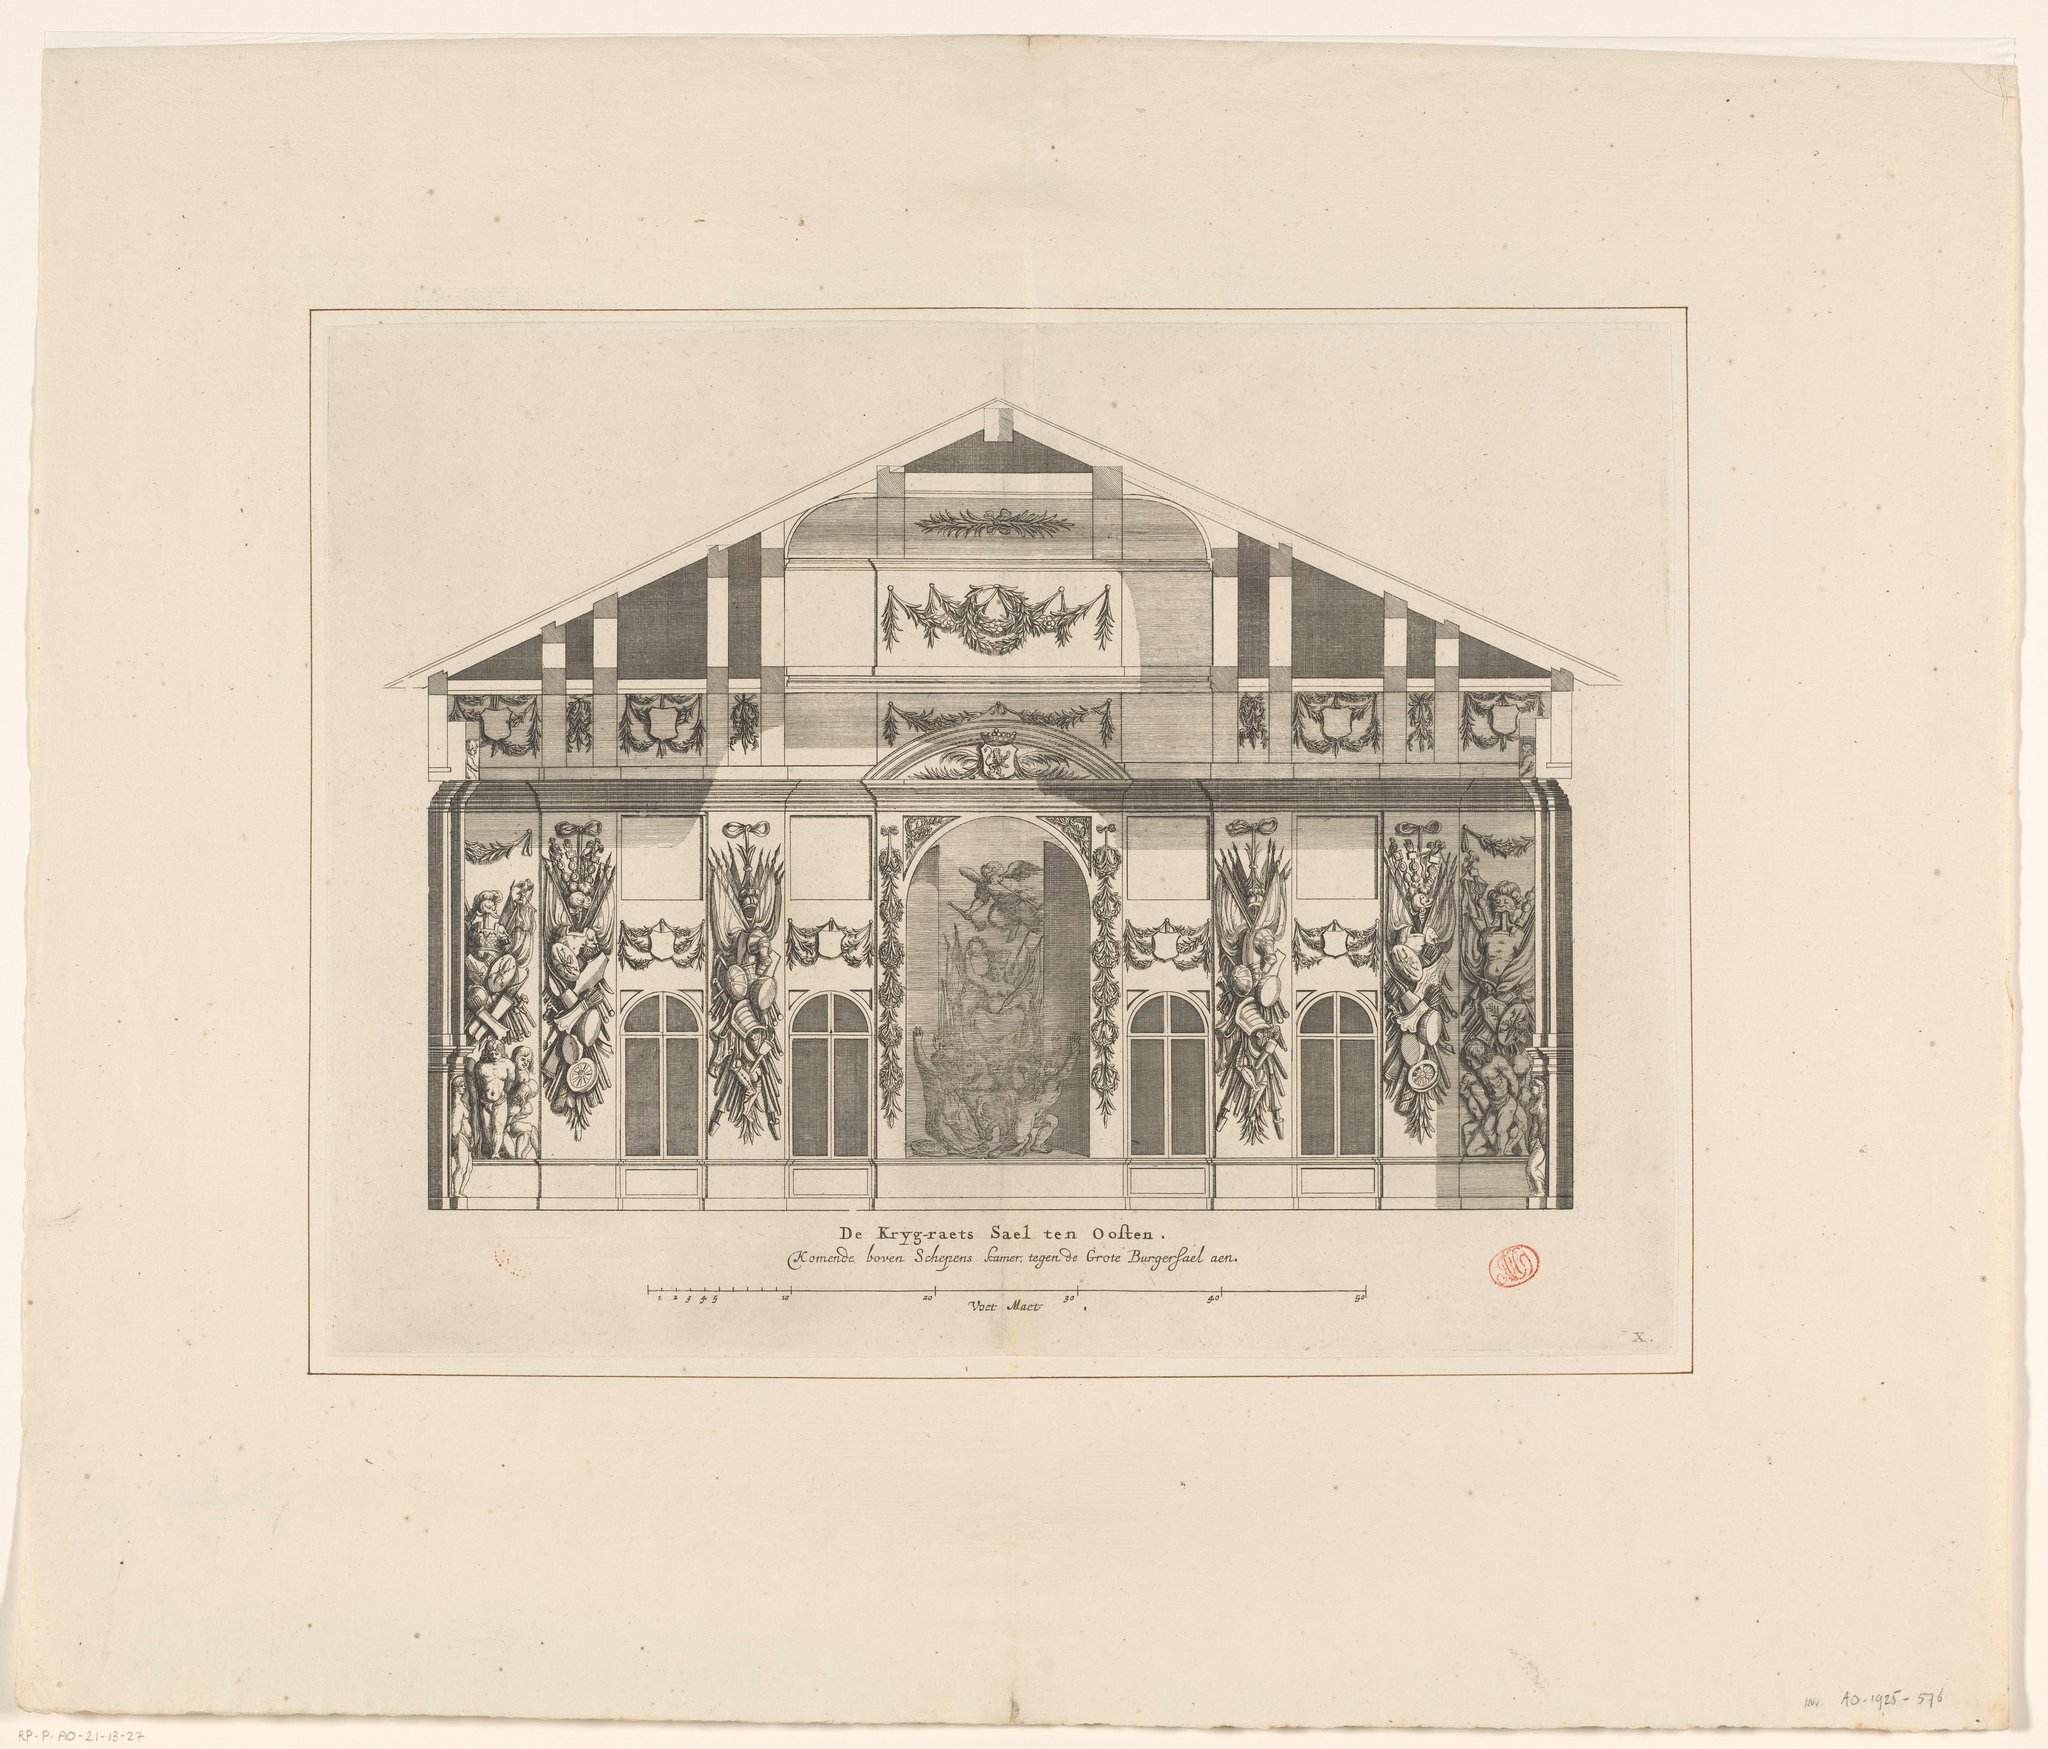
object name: book illustration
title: De Kryg-raets Sael ten Oosten. Komende boven Schepens kamer, tegen de Grote Burgersael aen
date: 1661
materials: paper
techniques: engraving, etching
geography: amsterdam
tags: interior ~ architectural design or model, weapons, fama as roman personification, townhall, interior ~ representation of a building, council of war, coat of arms (as symbol of the state, etc.) (+ province; provincial)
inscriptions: collector's mark: Lugt 195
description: De oostelijke wand van de Krijgsraadzaal in het Stadhuis op de Dam te Amsterdam, voorzien van decoraties. Deze zaal bevond zich boven de Schepenzaal. Onder de titel een schaalstok: 50 Voet Maet. Rechtsonder gemerkt: X.